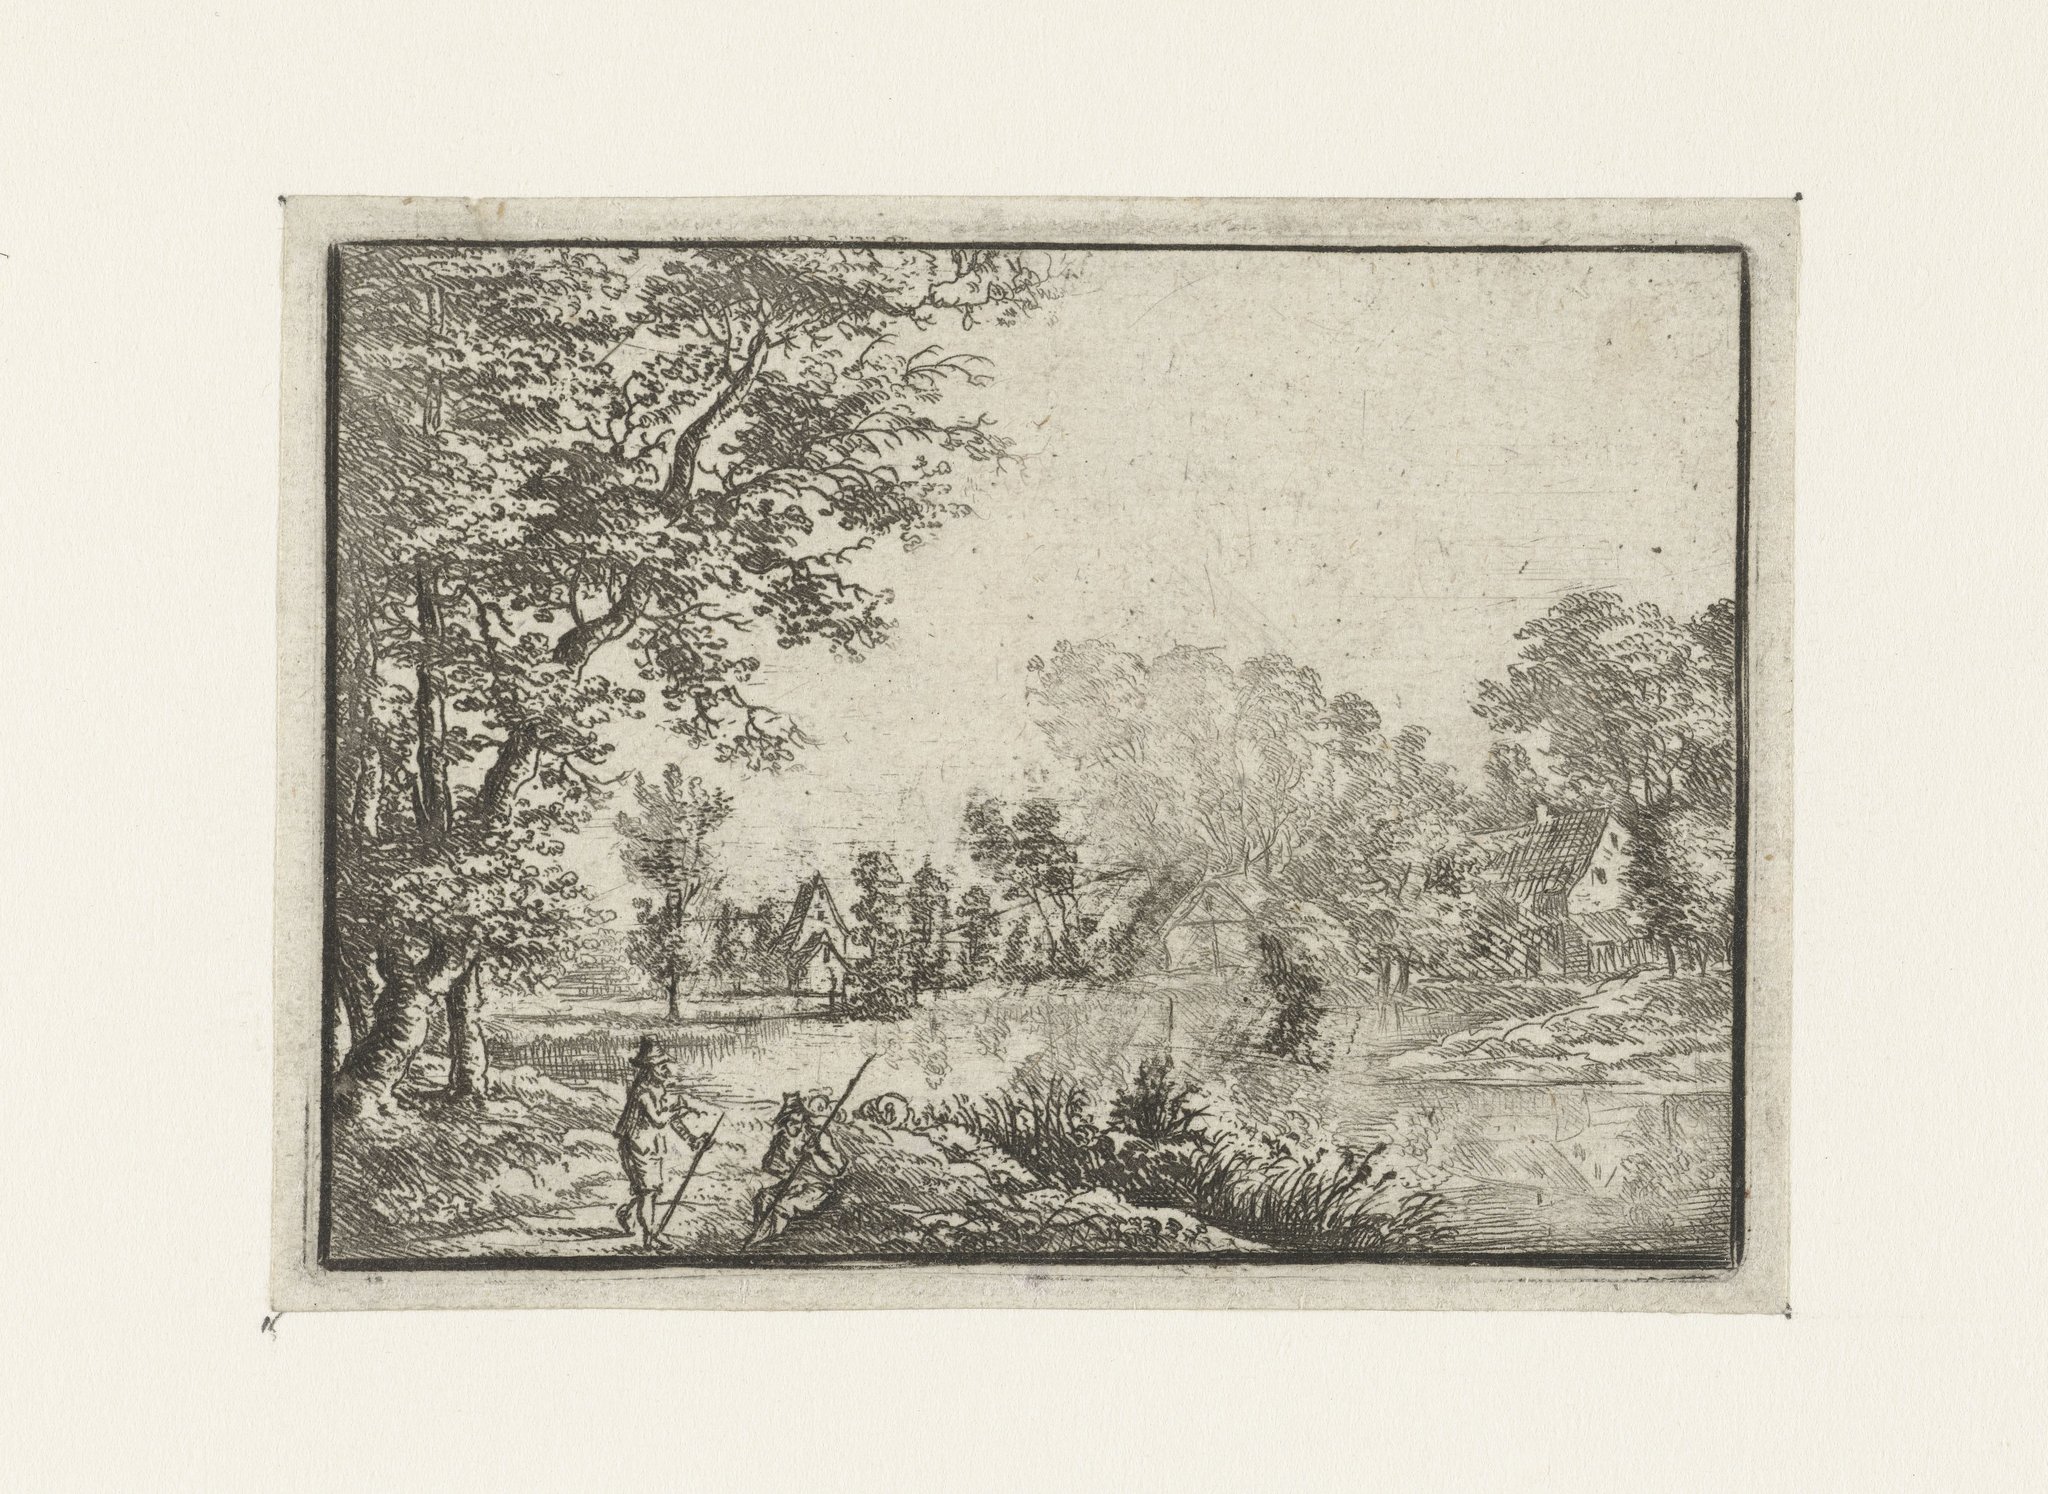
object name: print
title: Landschap met een dorp en twee mannen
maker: jan carel immenraet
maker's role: print maker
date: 1662-1663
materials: paper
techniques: engraving, etching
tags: river, village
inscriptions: collector's mark: Lugt 2228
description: Een dorp aan een rivier, twee mannen op de oever.